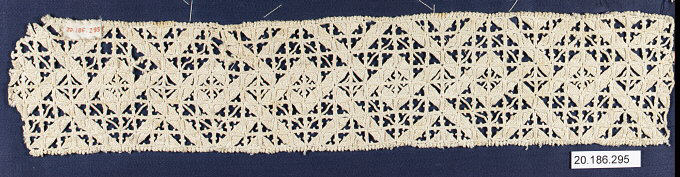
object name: insertion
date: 1501-1600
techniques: embroidery